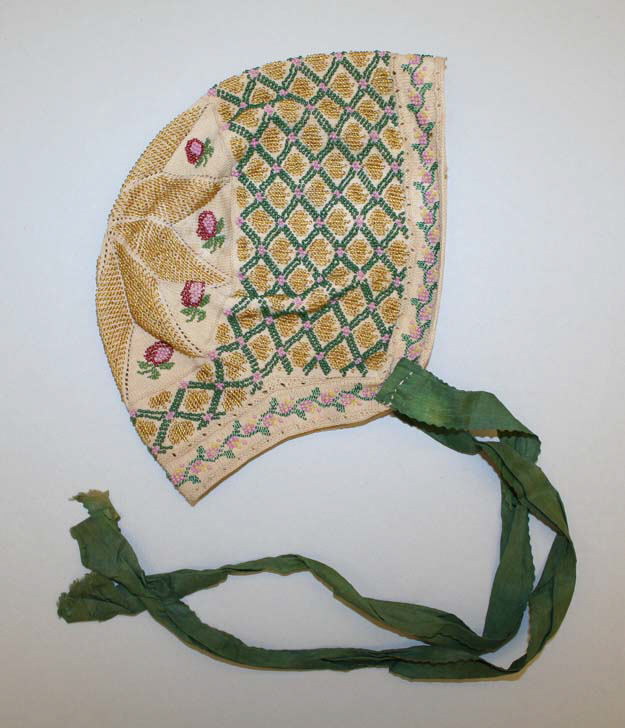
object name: cap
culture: european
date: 1801-1833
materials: cotton, glass, silk